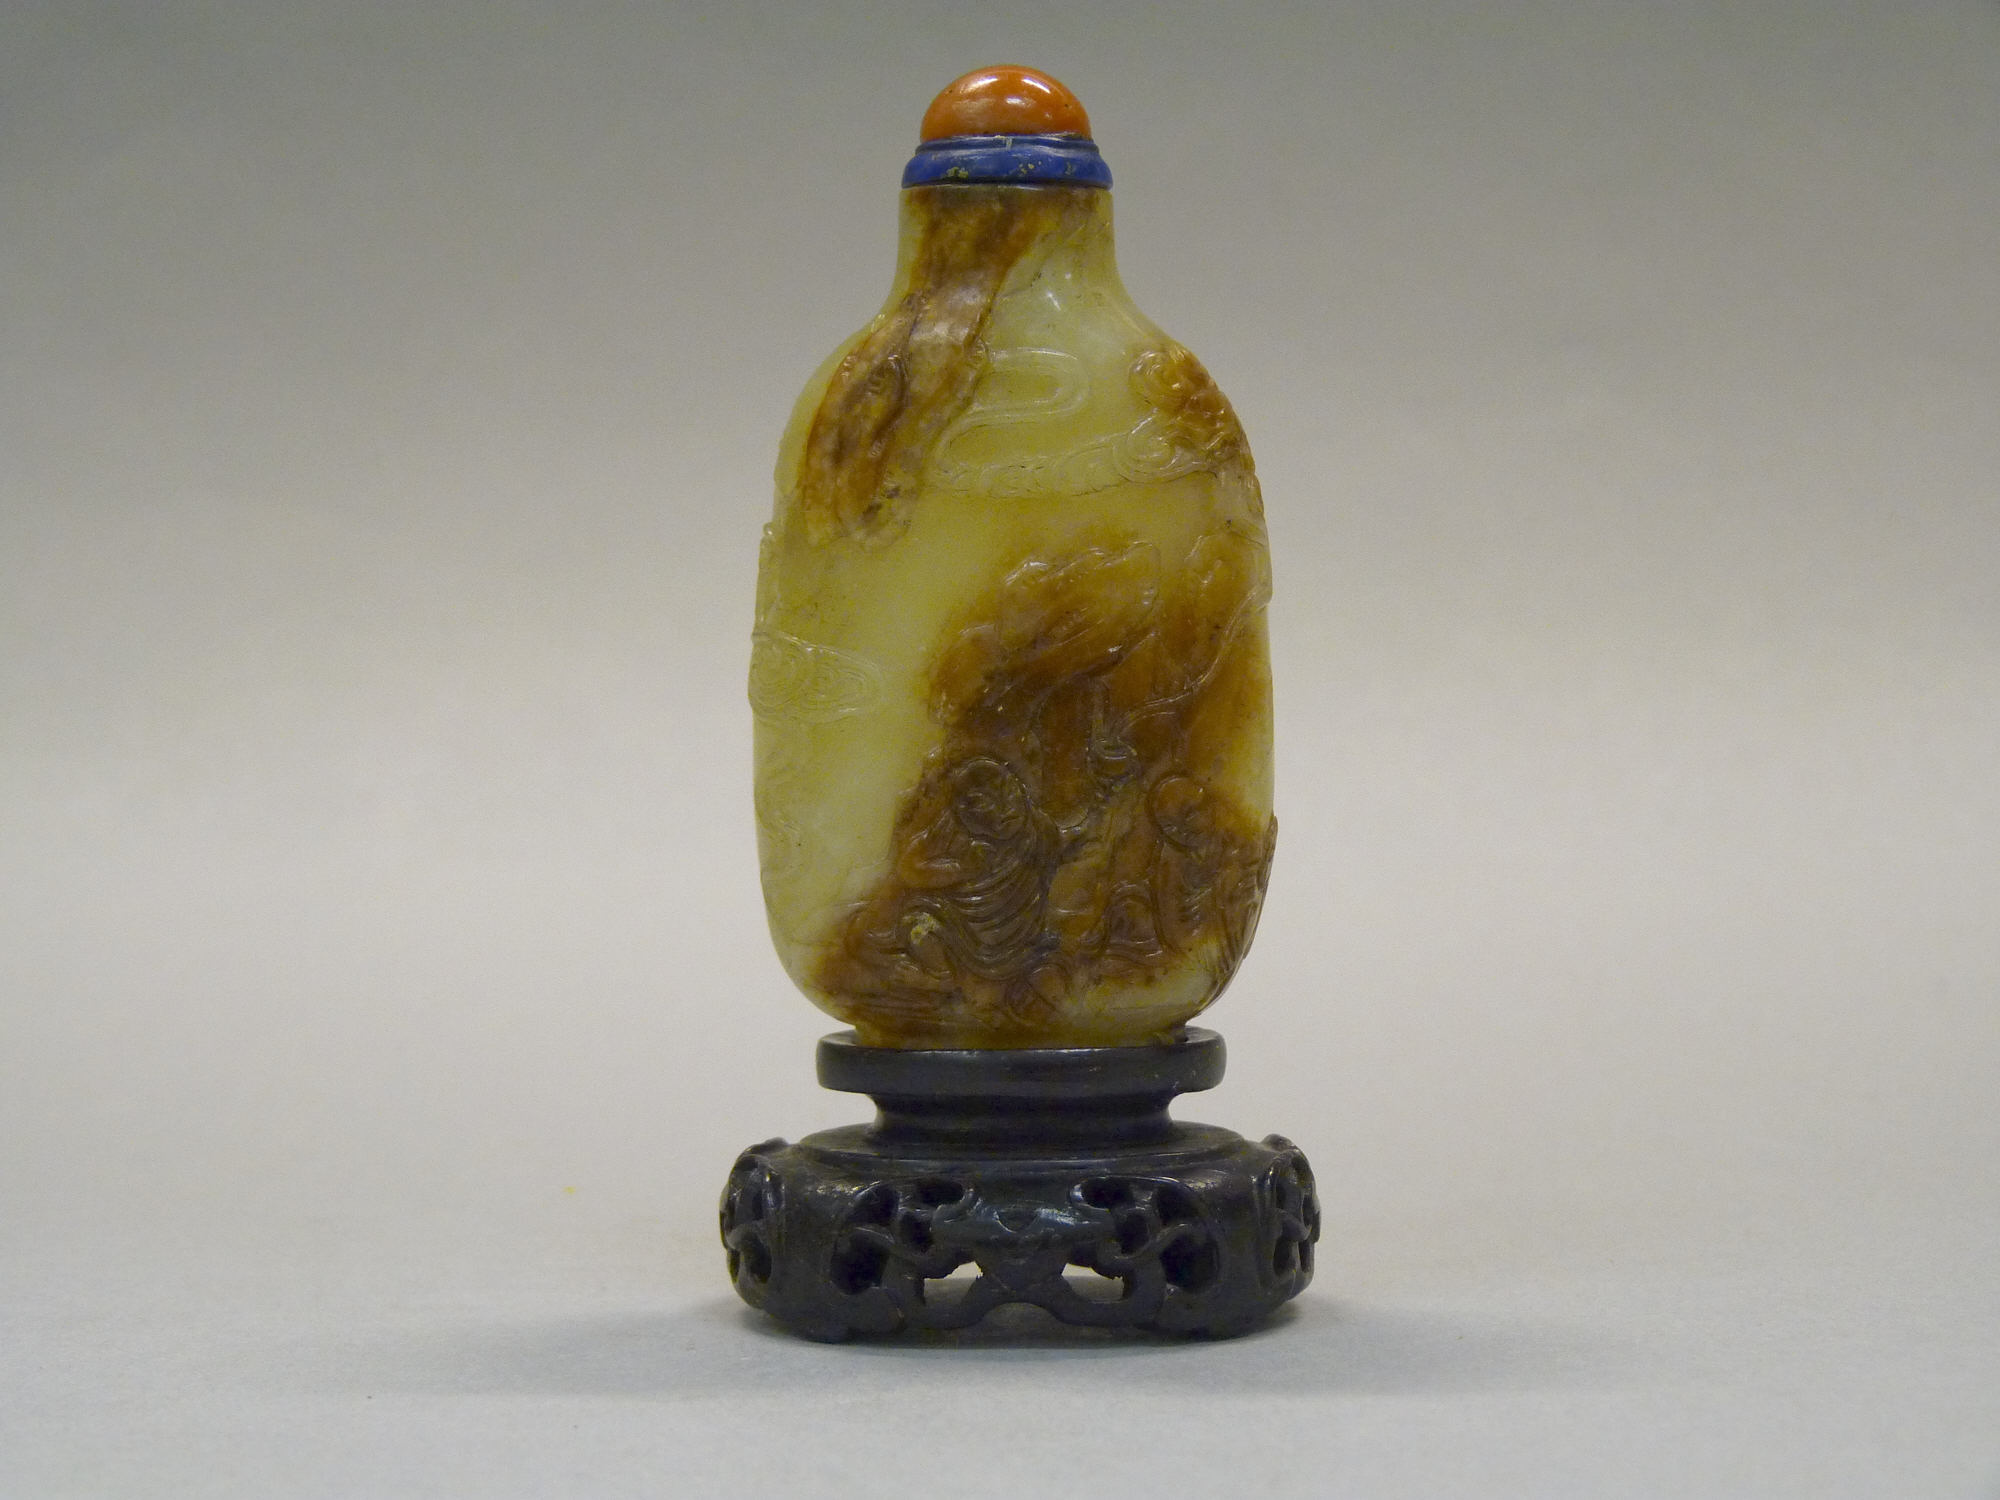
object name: snuff bottle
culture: chinese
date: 1736-1795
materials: coral, lapis lazuli, jade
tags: human figures